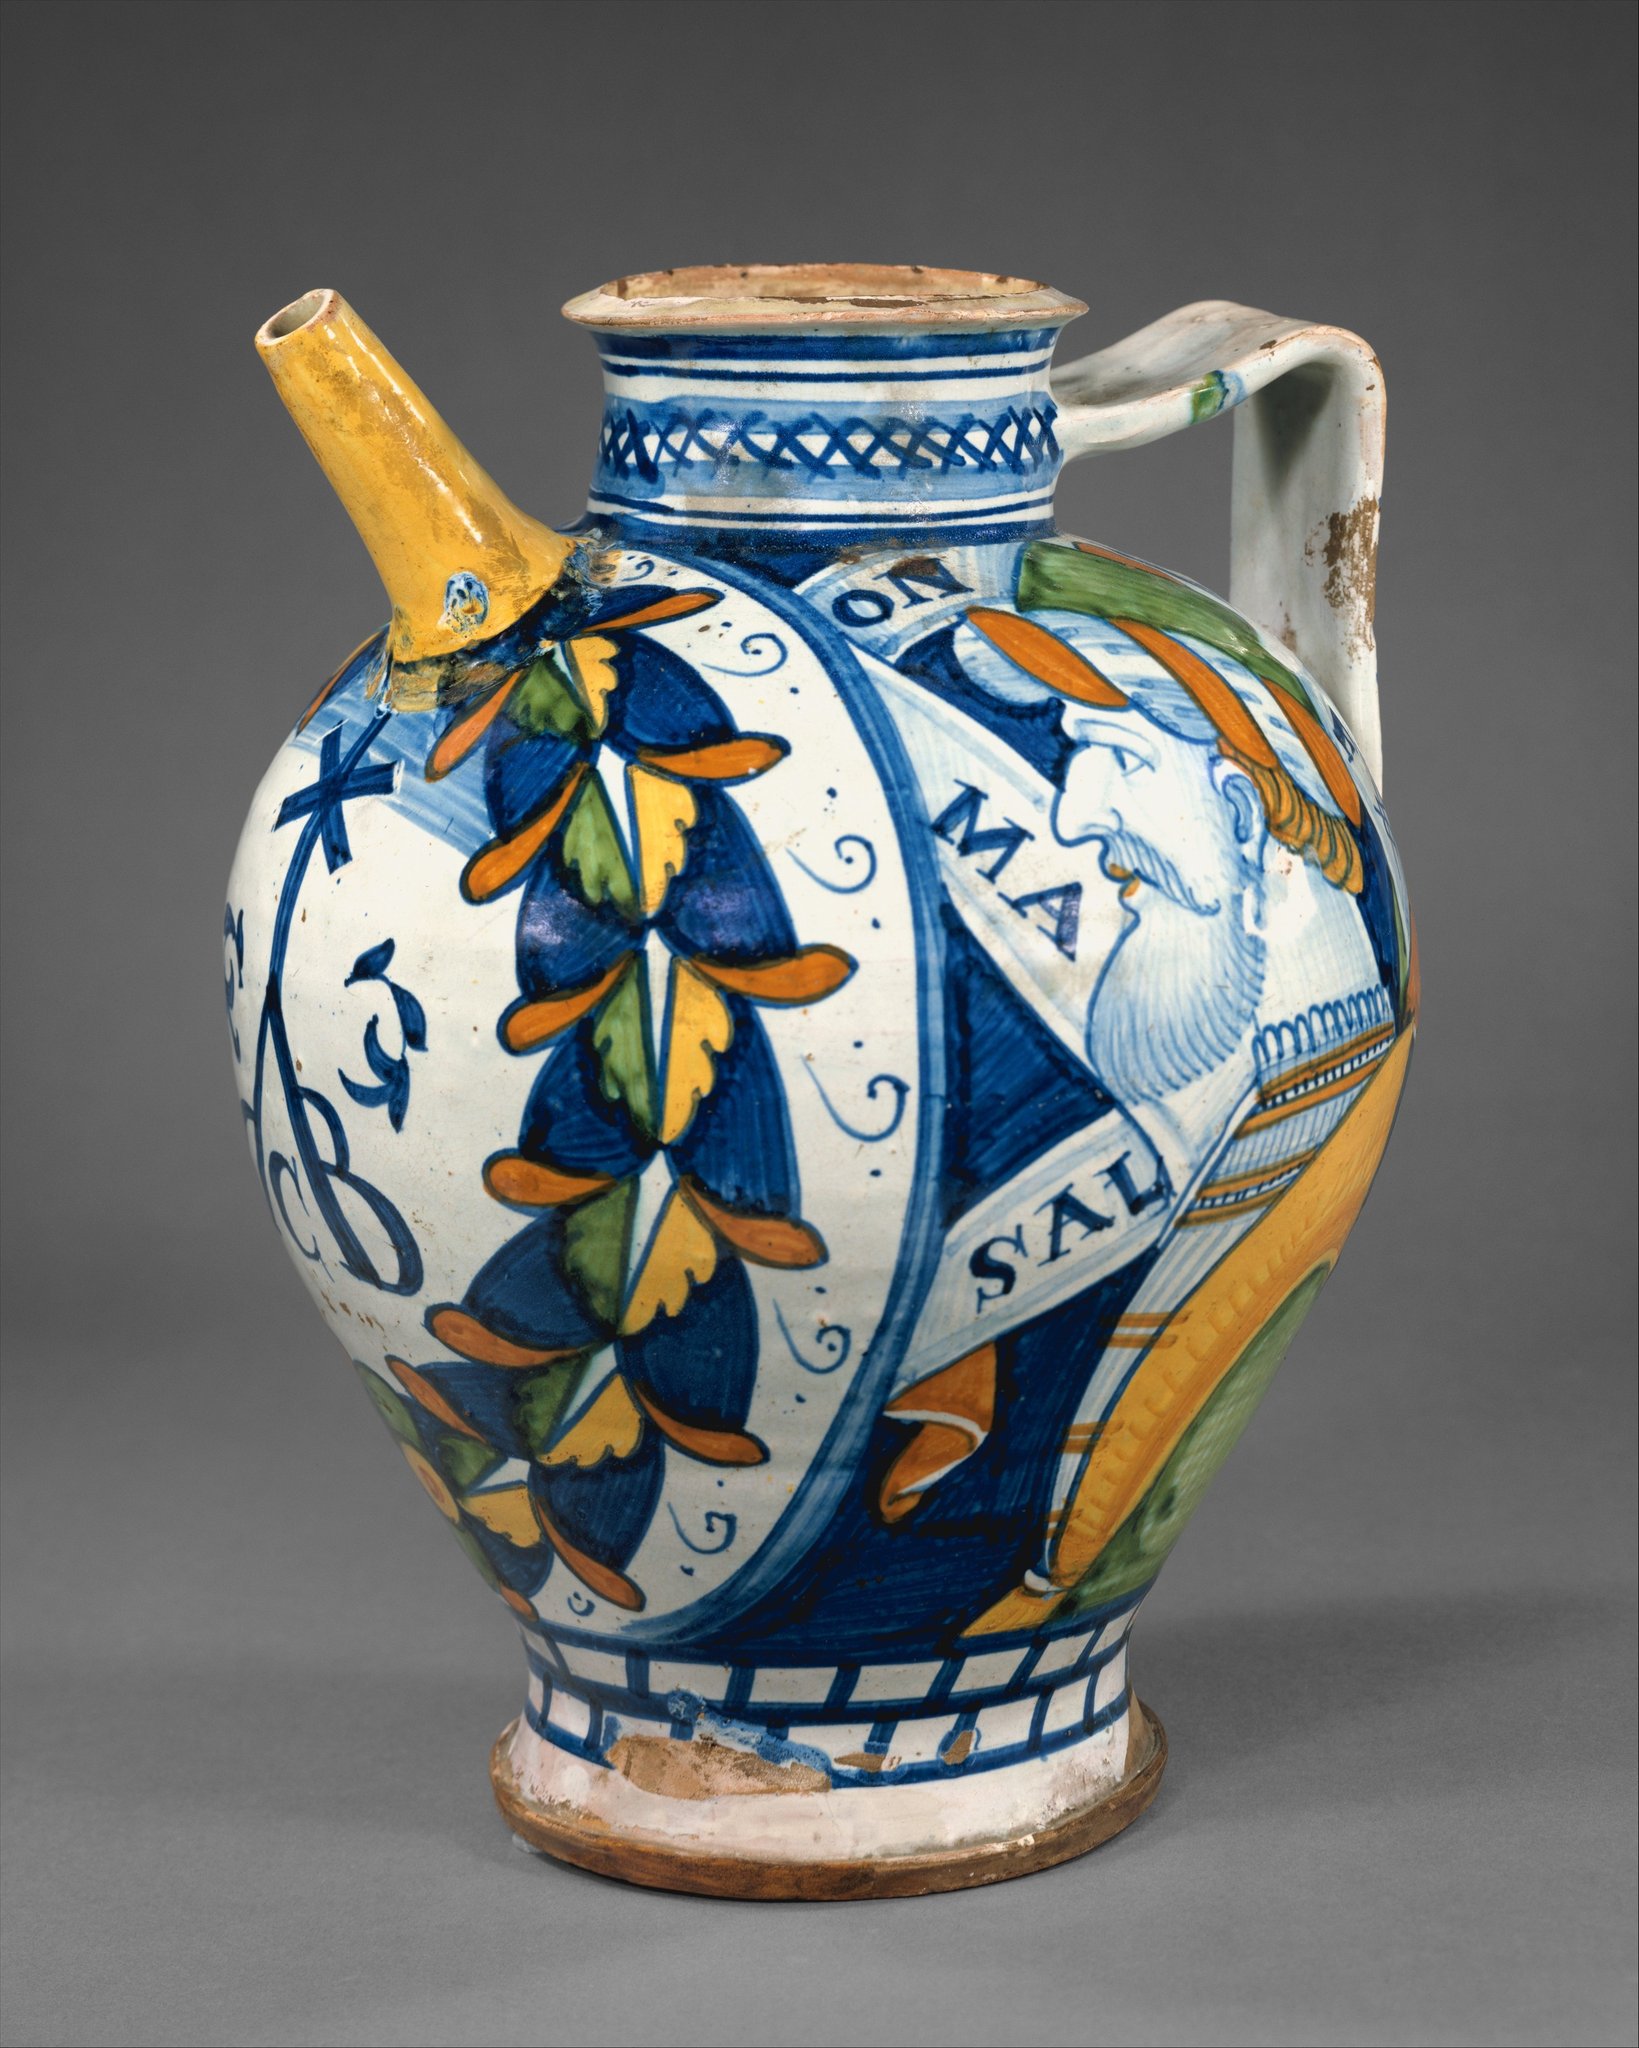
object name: apothecary jug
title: Maiolica: Apothecary jug (brocca)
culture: italian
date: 1501-1533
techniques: maiolica, glazing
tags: men,profiles